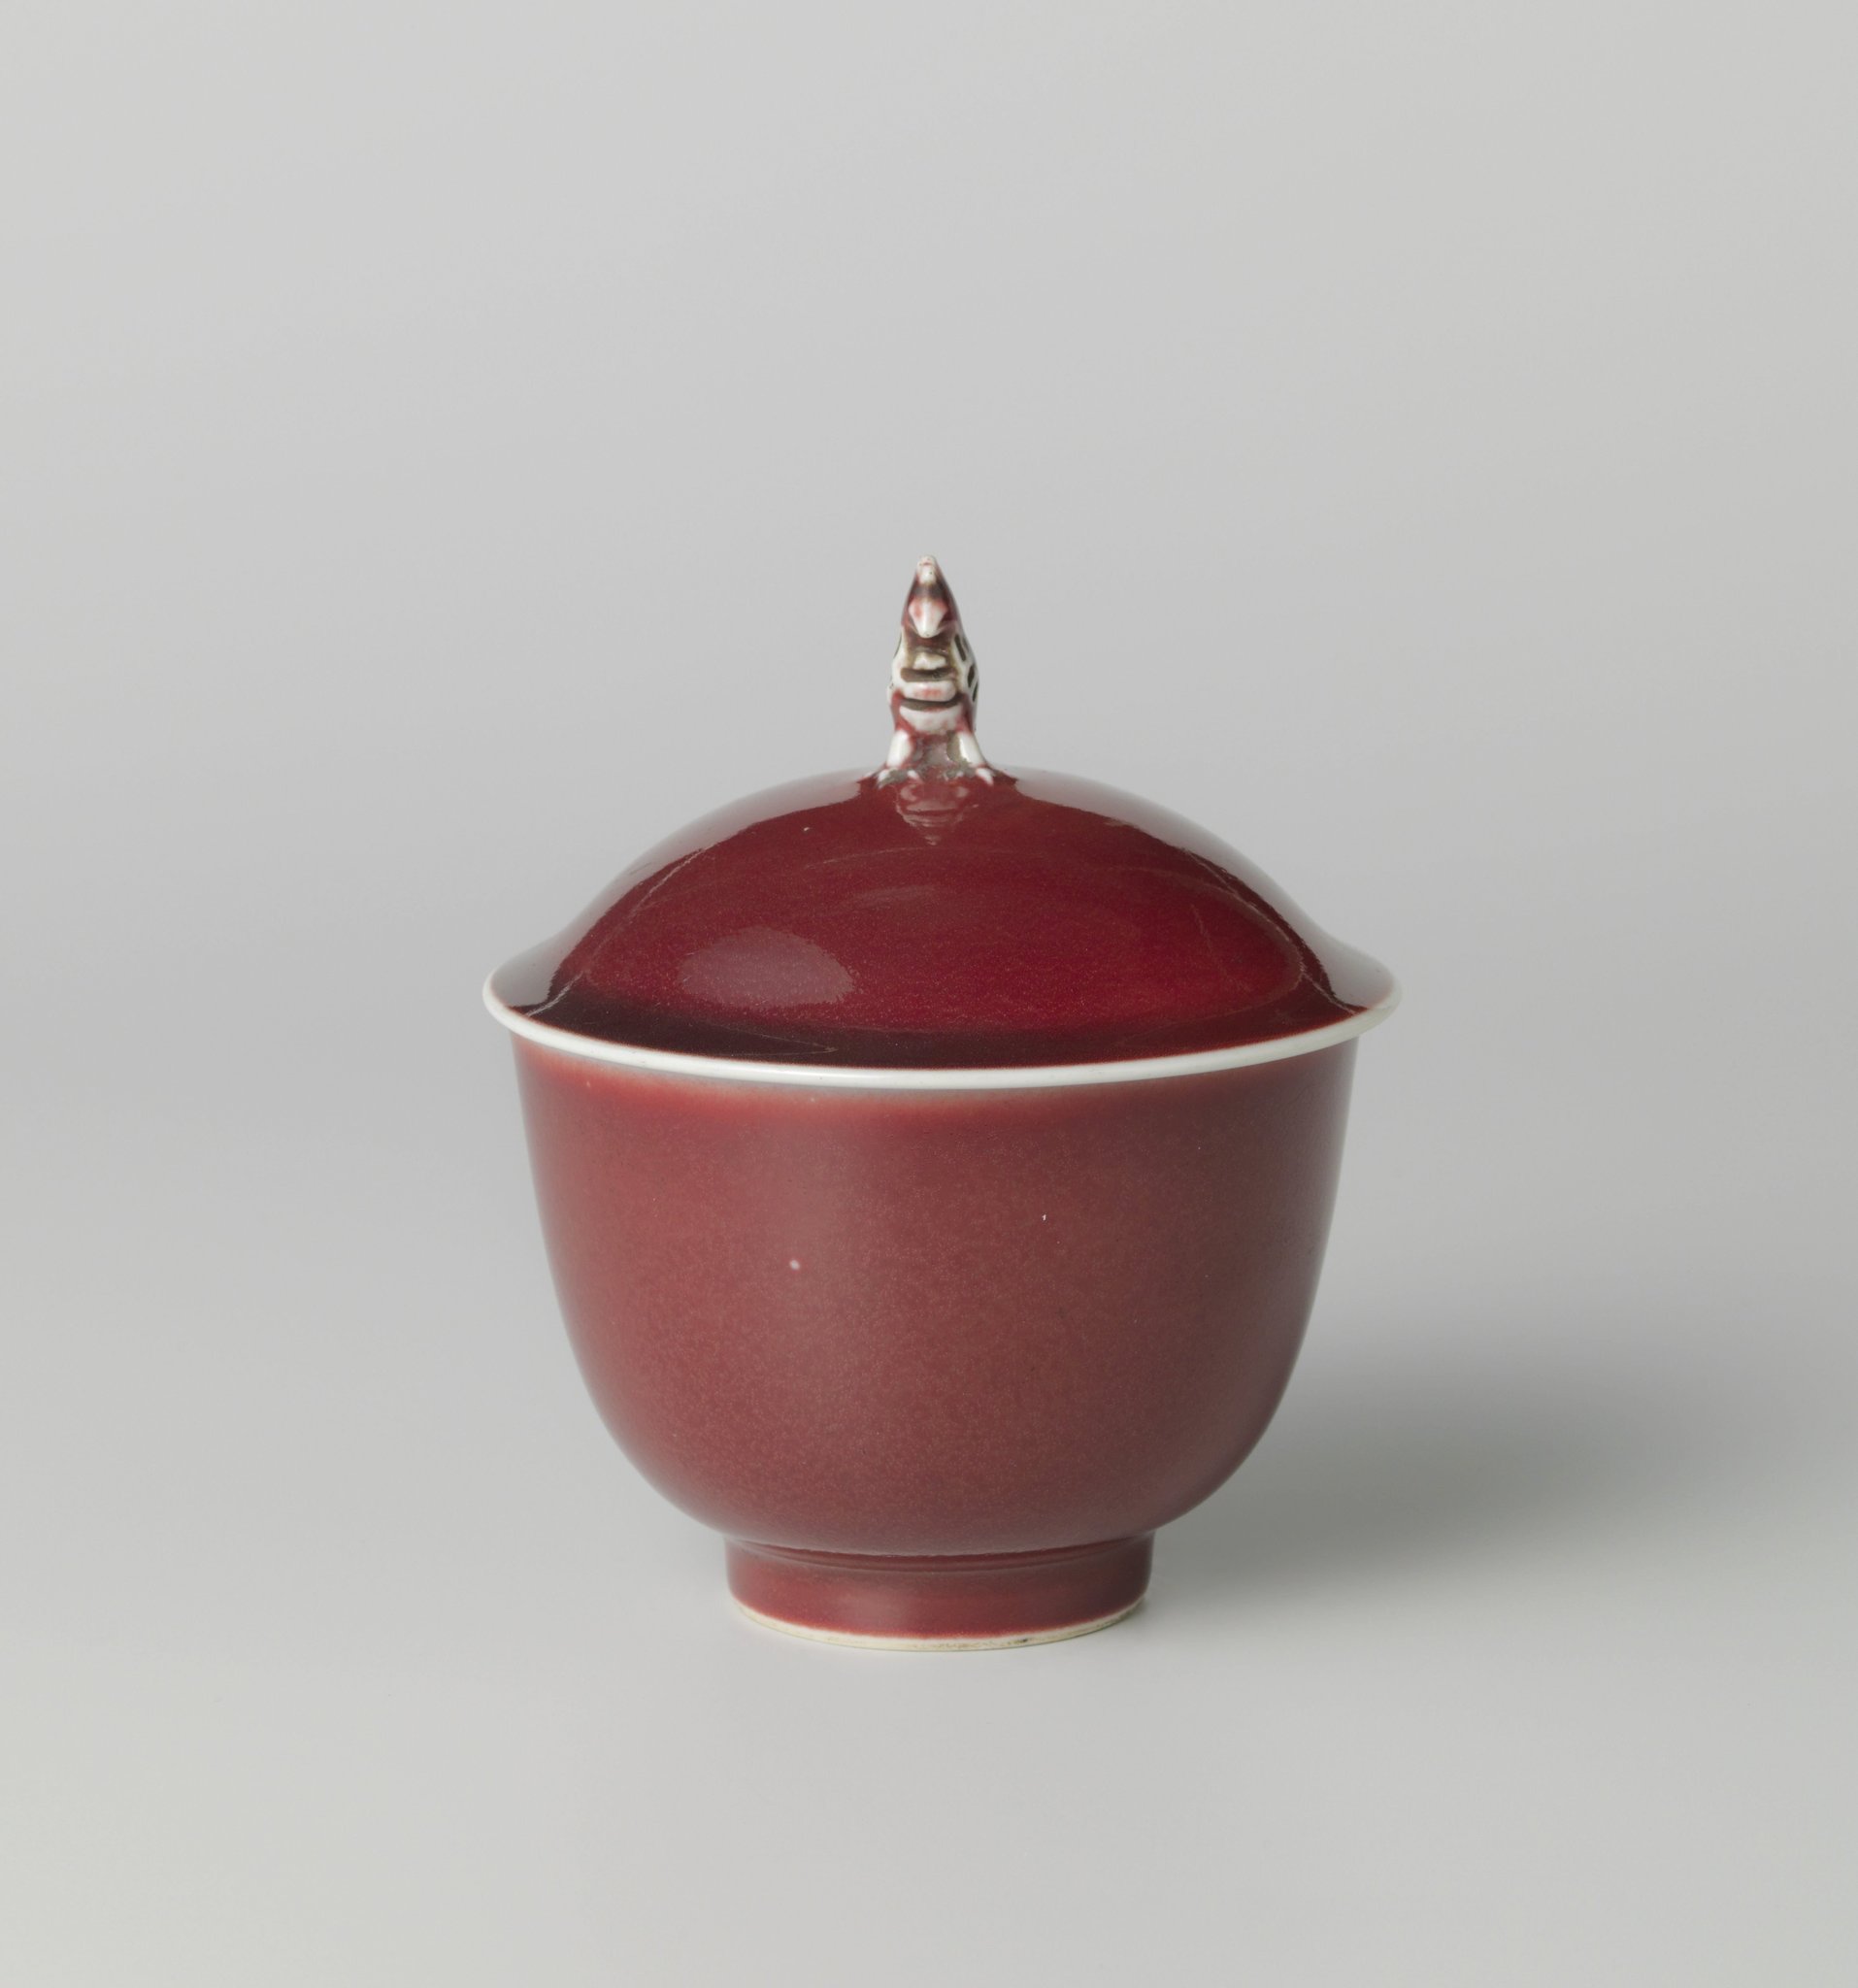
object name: covered jar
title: Covered jar with a red glaze and cock-shaped finial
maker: Anonymous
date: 1800-1899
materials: cobalt, glaze, porcelain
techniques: firing, forming, turning, vitrification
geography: china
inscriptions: mark: ‘大 清 雍 正 年 製’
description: Deksel met in de vorm van een haan van dekselpot van porselein, bedekt met een monochroom rood glazuur. Binnen de voetring een doorschijnend glazuur met het zes-karaktermerk van keier Yongzheng in een dubbele cirkel. De randen zijn wit. Monochromen.